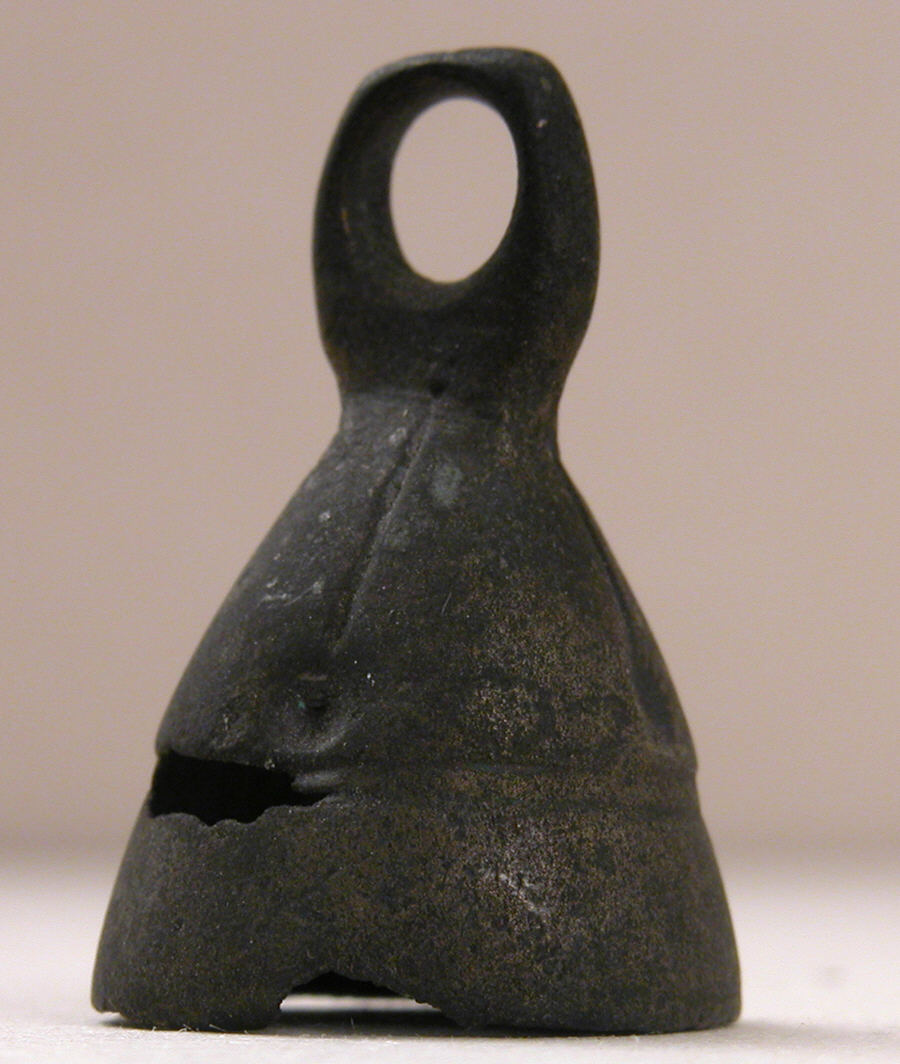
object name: bell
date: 401-800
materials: bronze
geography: palestine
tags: musical instruments